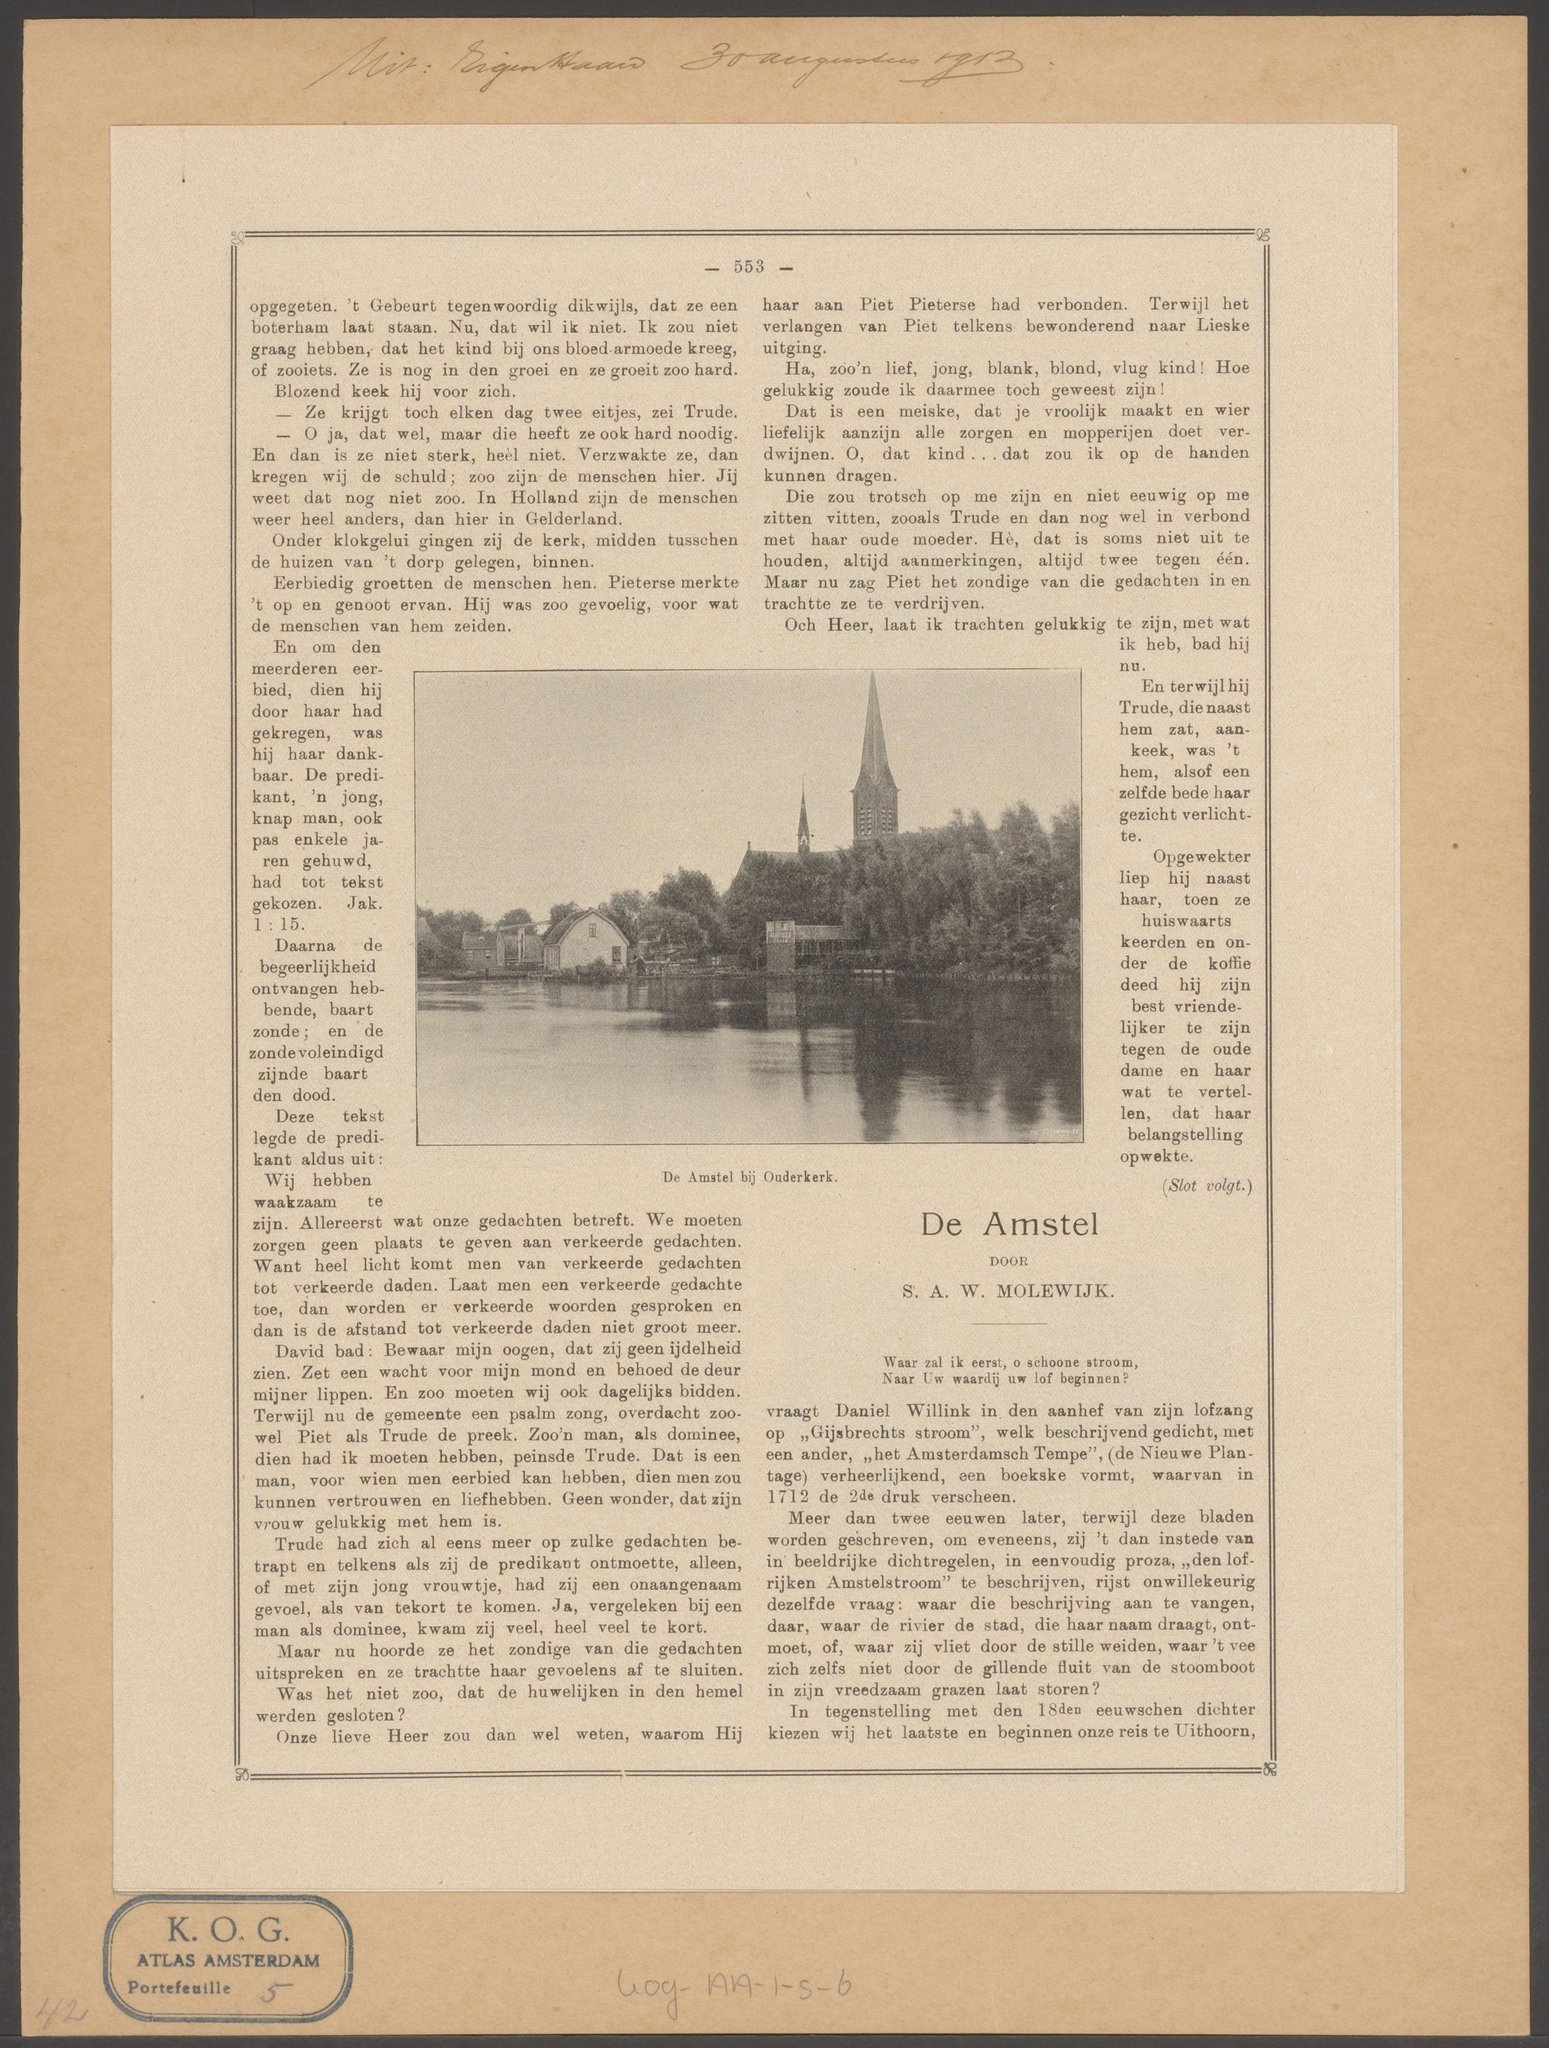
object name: page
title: Gezicht op de Amstel bij Ouderkerk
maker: Anonymous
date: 1913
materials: paper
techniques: letterpress printing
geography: haarlem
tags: river, village, parts of church exterior and annexes: spire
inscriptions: collector's mark: ‘5’ Lugt 1641b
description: Onderwerpsrubriek binnen de Atlas Amsterdam: Amstel buiten de stad, Amsteldijk.